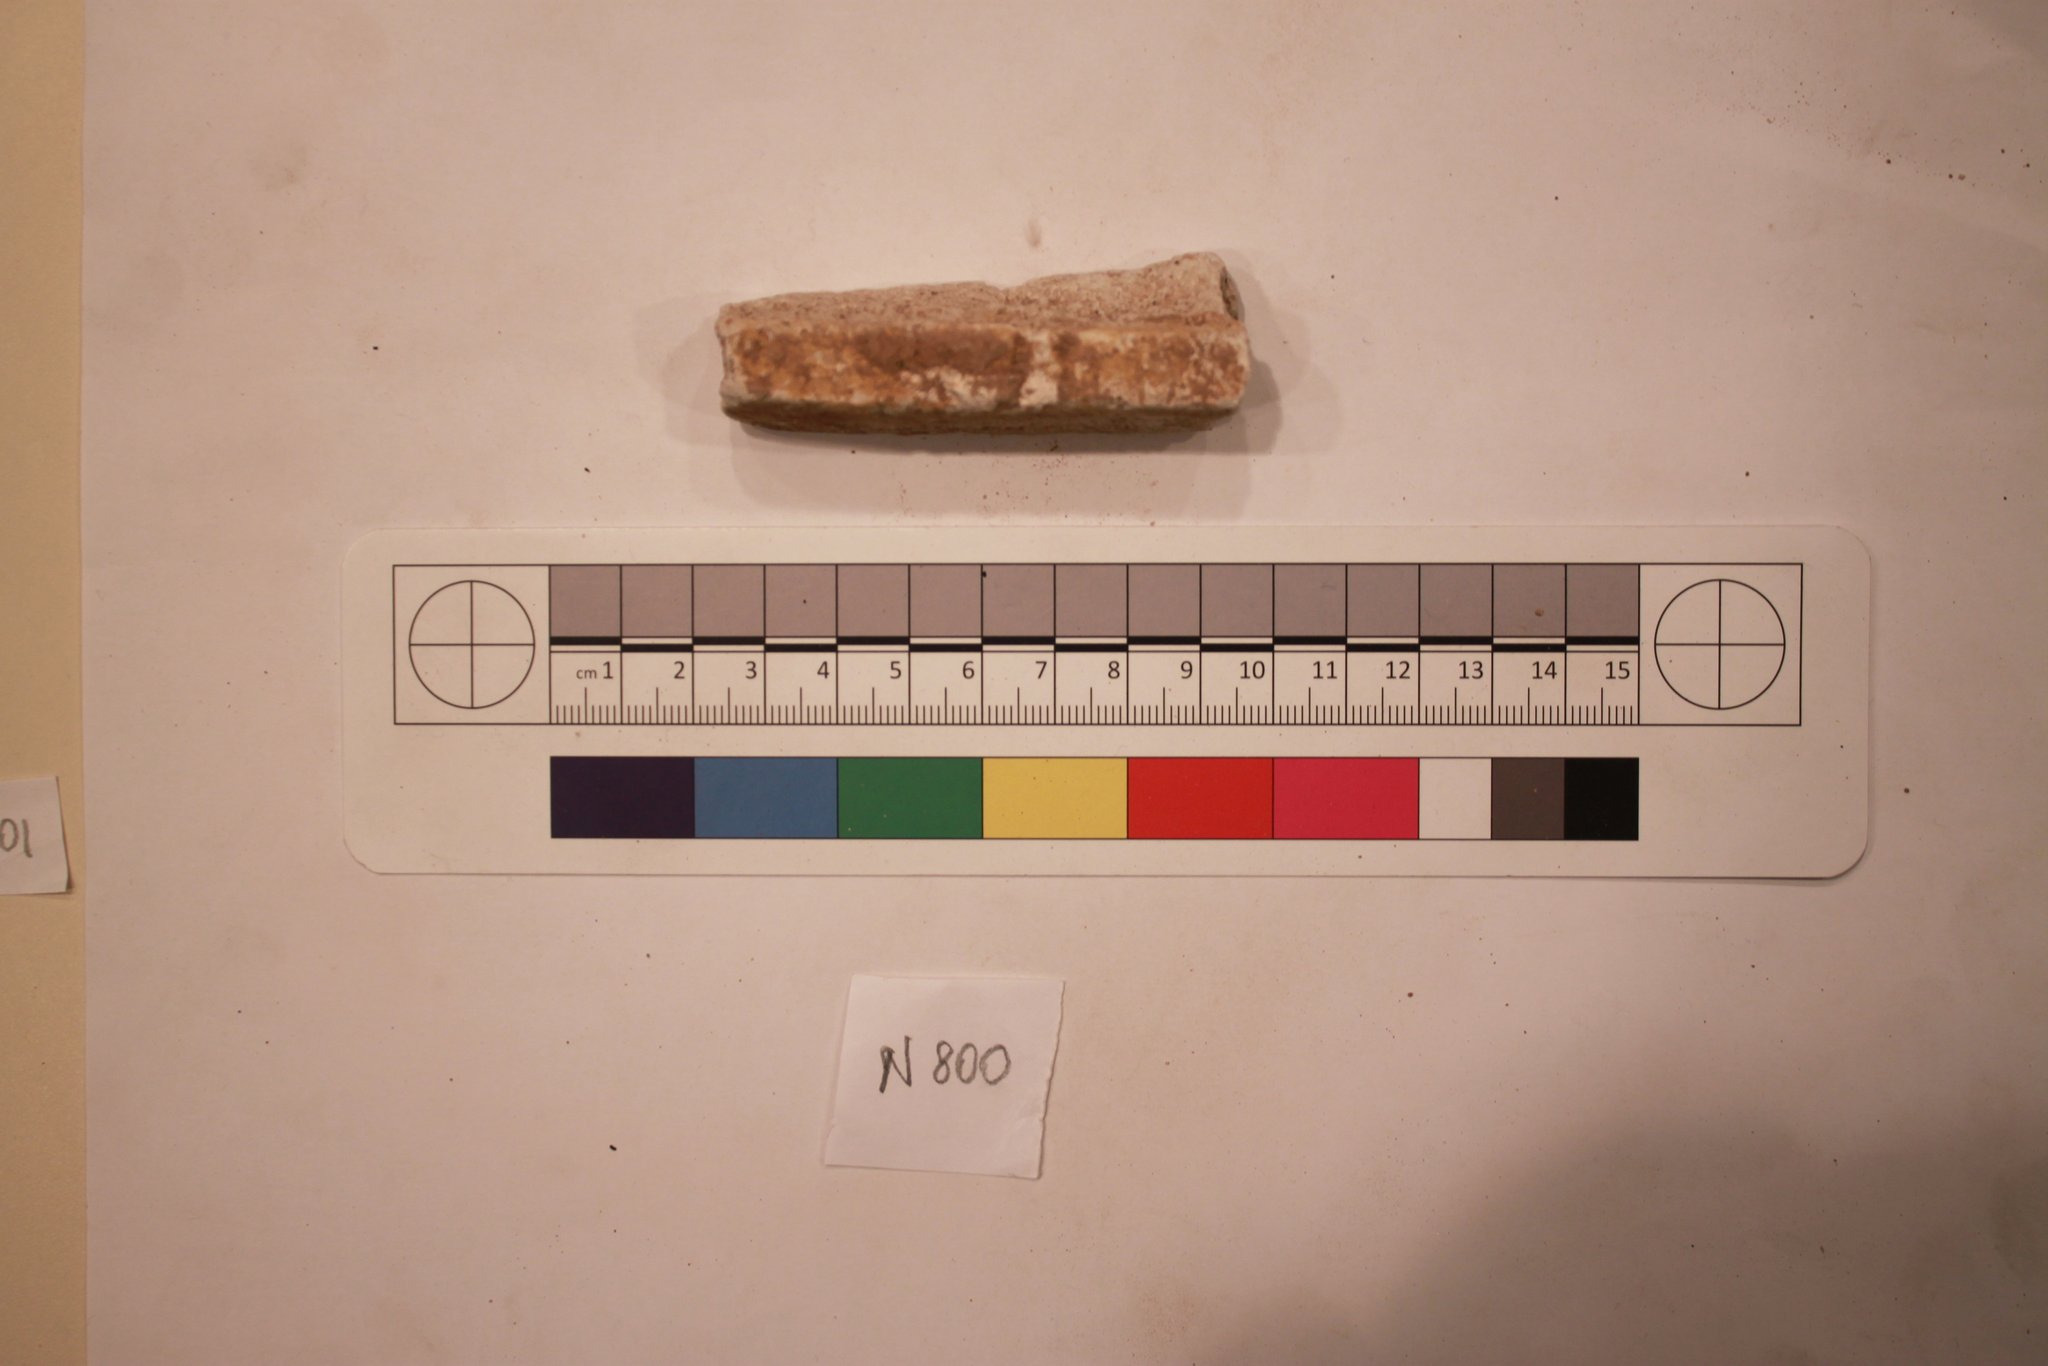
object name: fragment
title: Stucco Fragment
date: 701-1200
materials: plaster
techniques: carving, painting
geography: iran